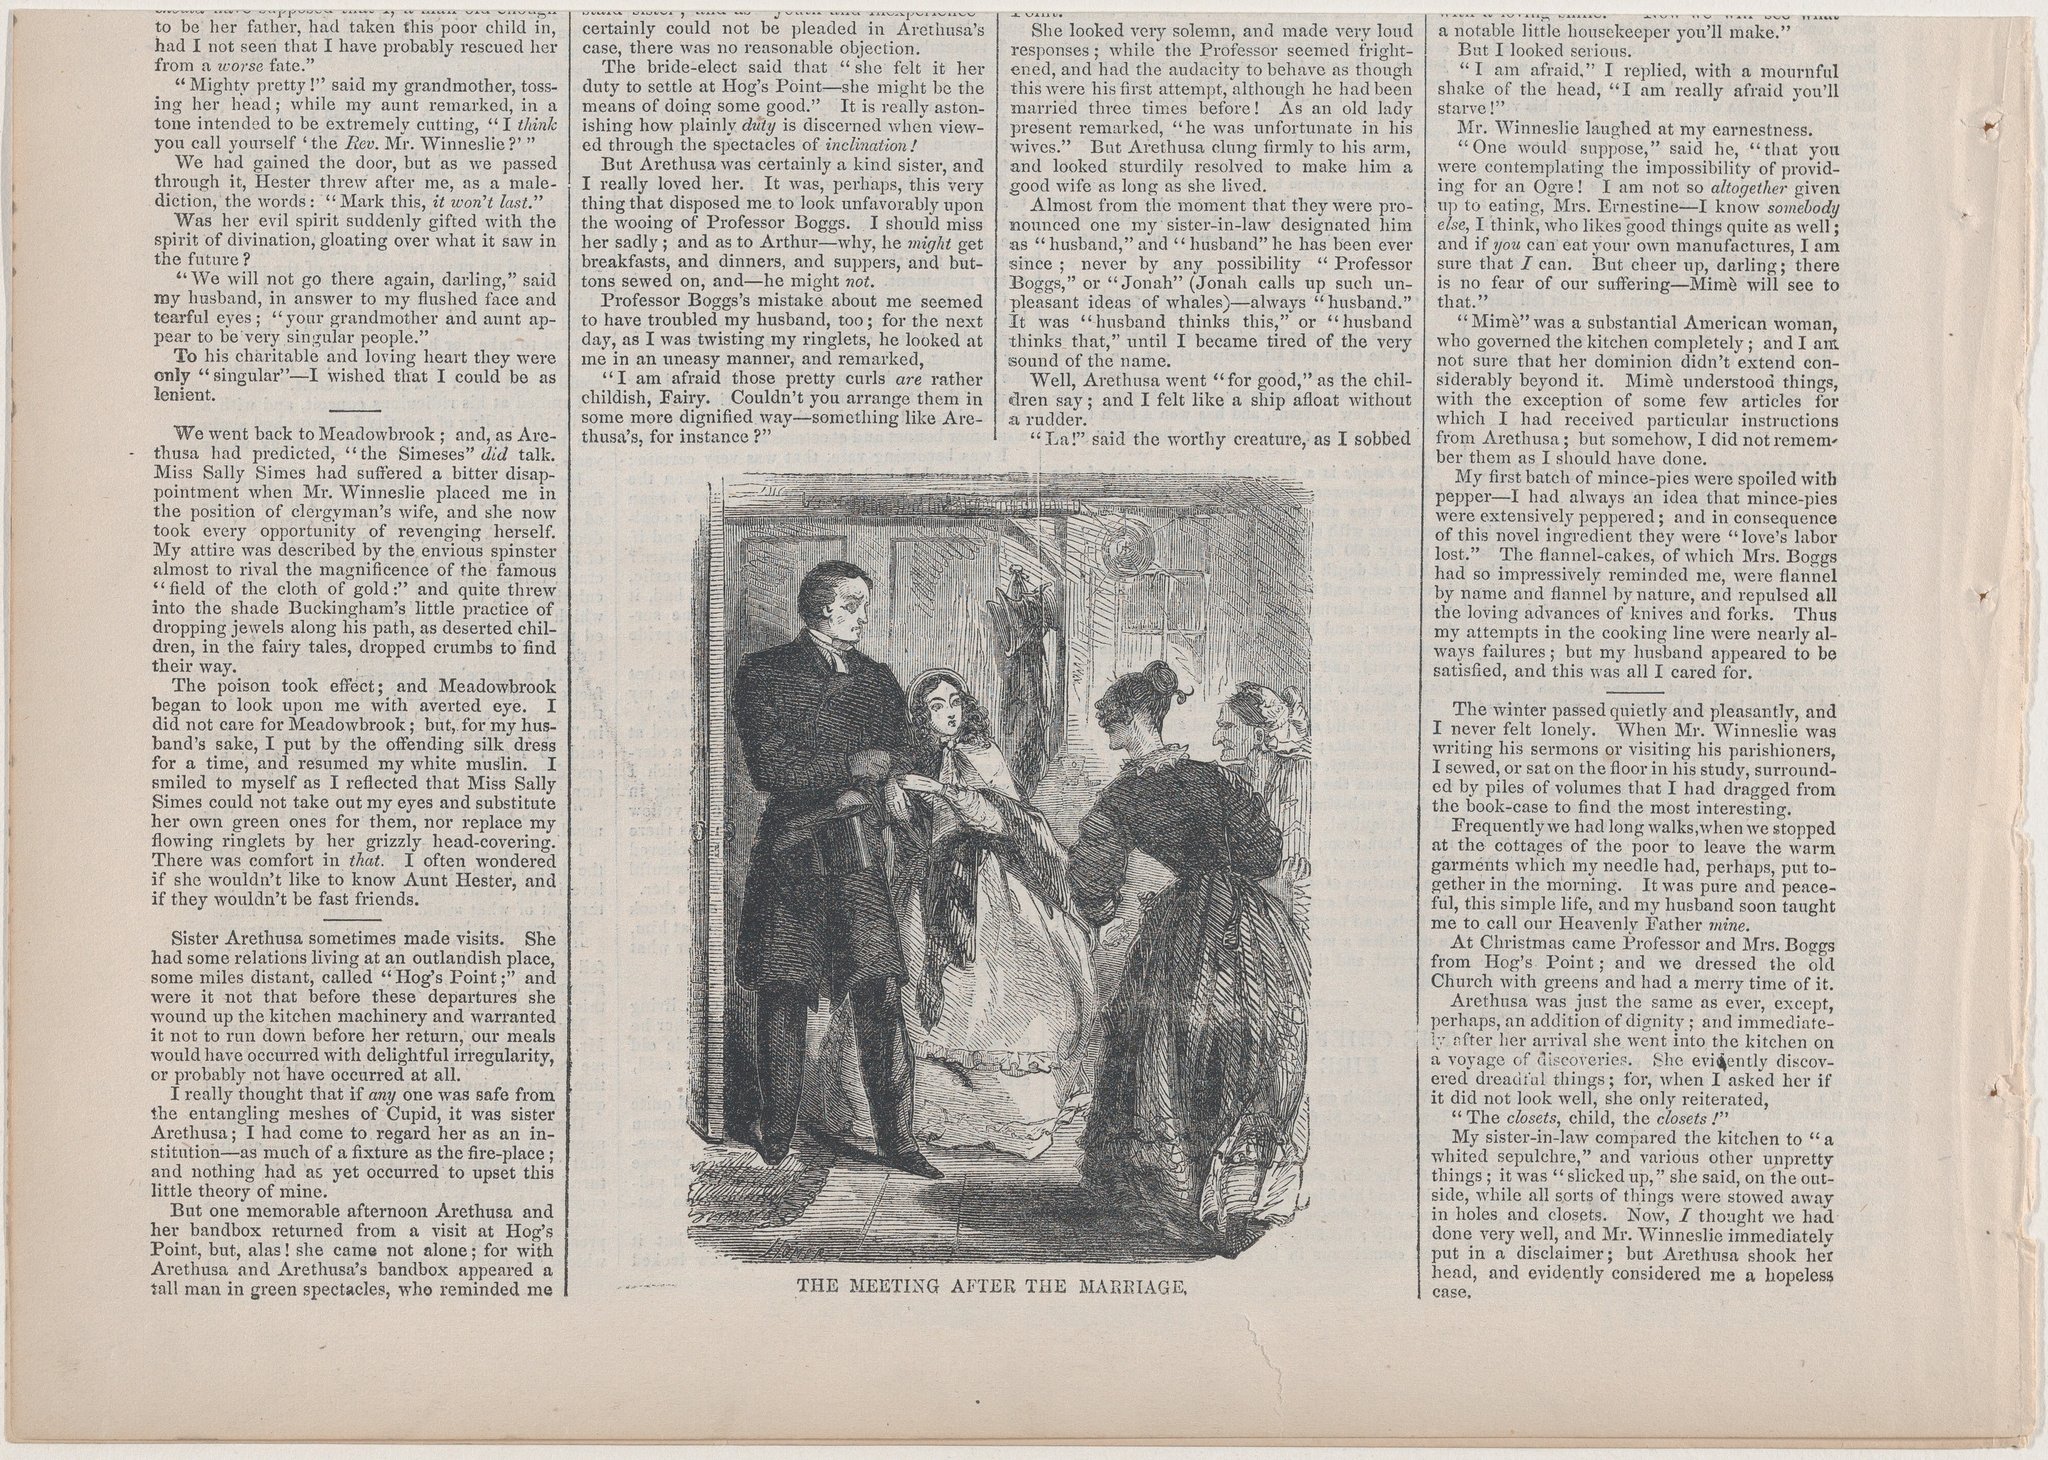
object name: print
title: The Meeting After the Marriage (from "The Mistress of the Parsonage," in "Harper's Weekly")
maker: winslow homer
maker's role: artist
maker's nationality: american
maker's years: 1836-1910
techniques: engraving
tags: men,women